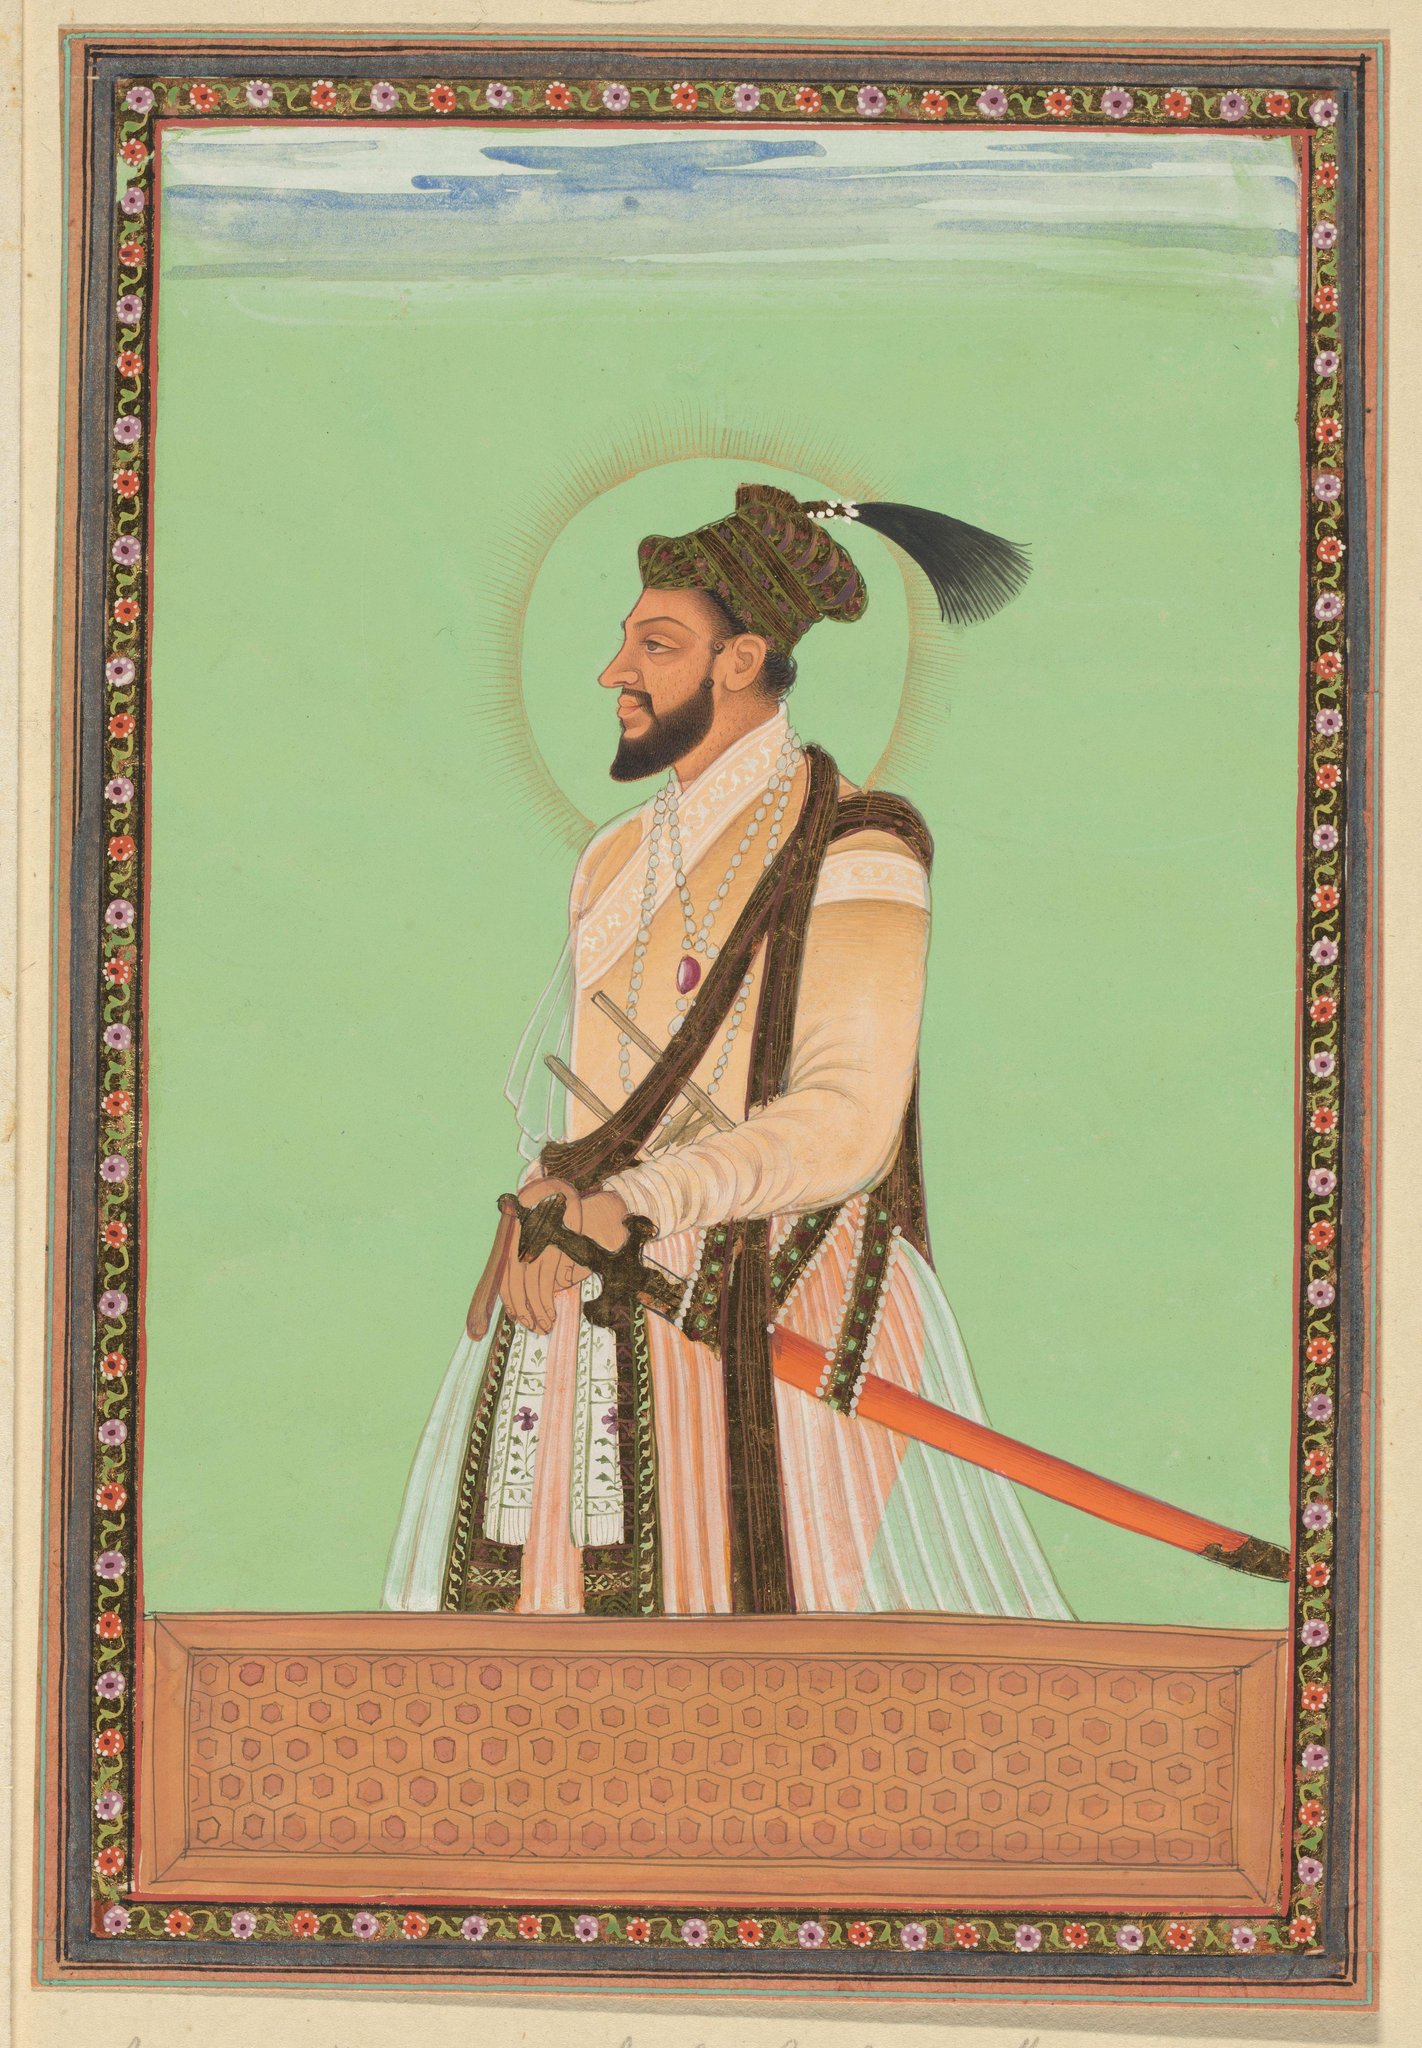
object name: drawing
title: Portret van Shuja, de zoon van Shah Jahan, die na Dara Shikoh is geboren en in de tijd van zijn vader regeerde over Bengalen; na de dood van zijn vader heeft Aurangzeb hem gedood en Bengalen in bezit genomen.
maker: Anonymous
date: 1686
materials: paint, gold leaf, gouache, paper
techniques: brush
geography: golkonda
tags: amsterdam, print maker, mayor, nicolaes cornelisz. witsen, historical person (...) - historical person (...) portrayed alone, ruler, sovereign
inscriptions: collector's mark: Lugt 1838, annotation: ‘Stegia, Zoon van Stah Gichan, Koning van Bengalen ook genoemd Sultan Sujah’, collector's mark: Lugt 240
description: Shuja is tot aan zijn heupen afgebeeld, naar links gewend, zijn handen gevouwen voor zich, aan zijn linker zijde een zwaard, in zijn gordel een kattar. Blad 9 in het `Witsen-Album', met 49 Indiase miniaturen van vorsten. Boven het portret een stukje papier met de naam in het Perzisch. Onder het portret een stukje papier met de naam in het Portugees.